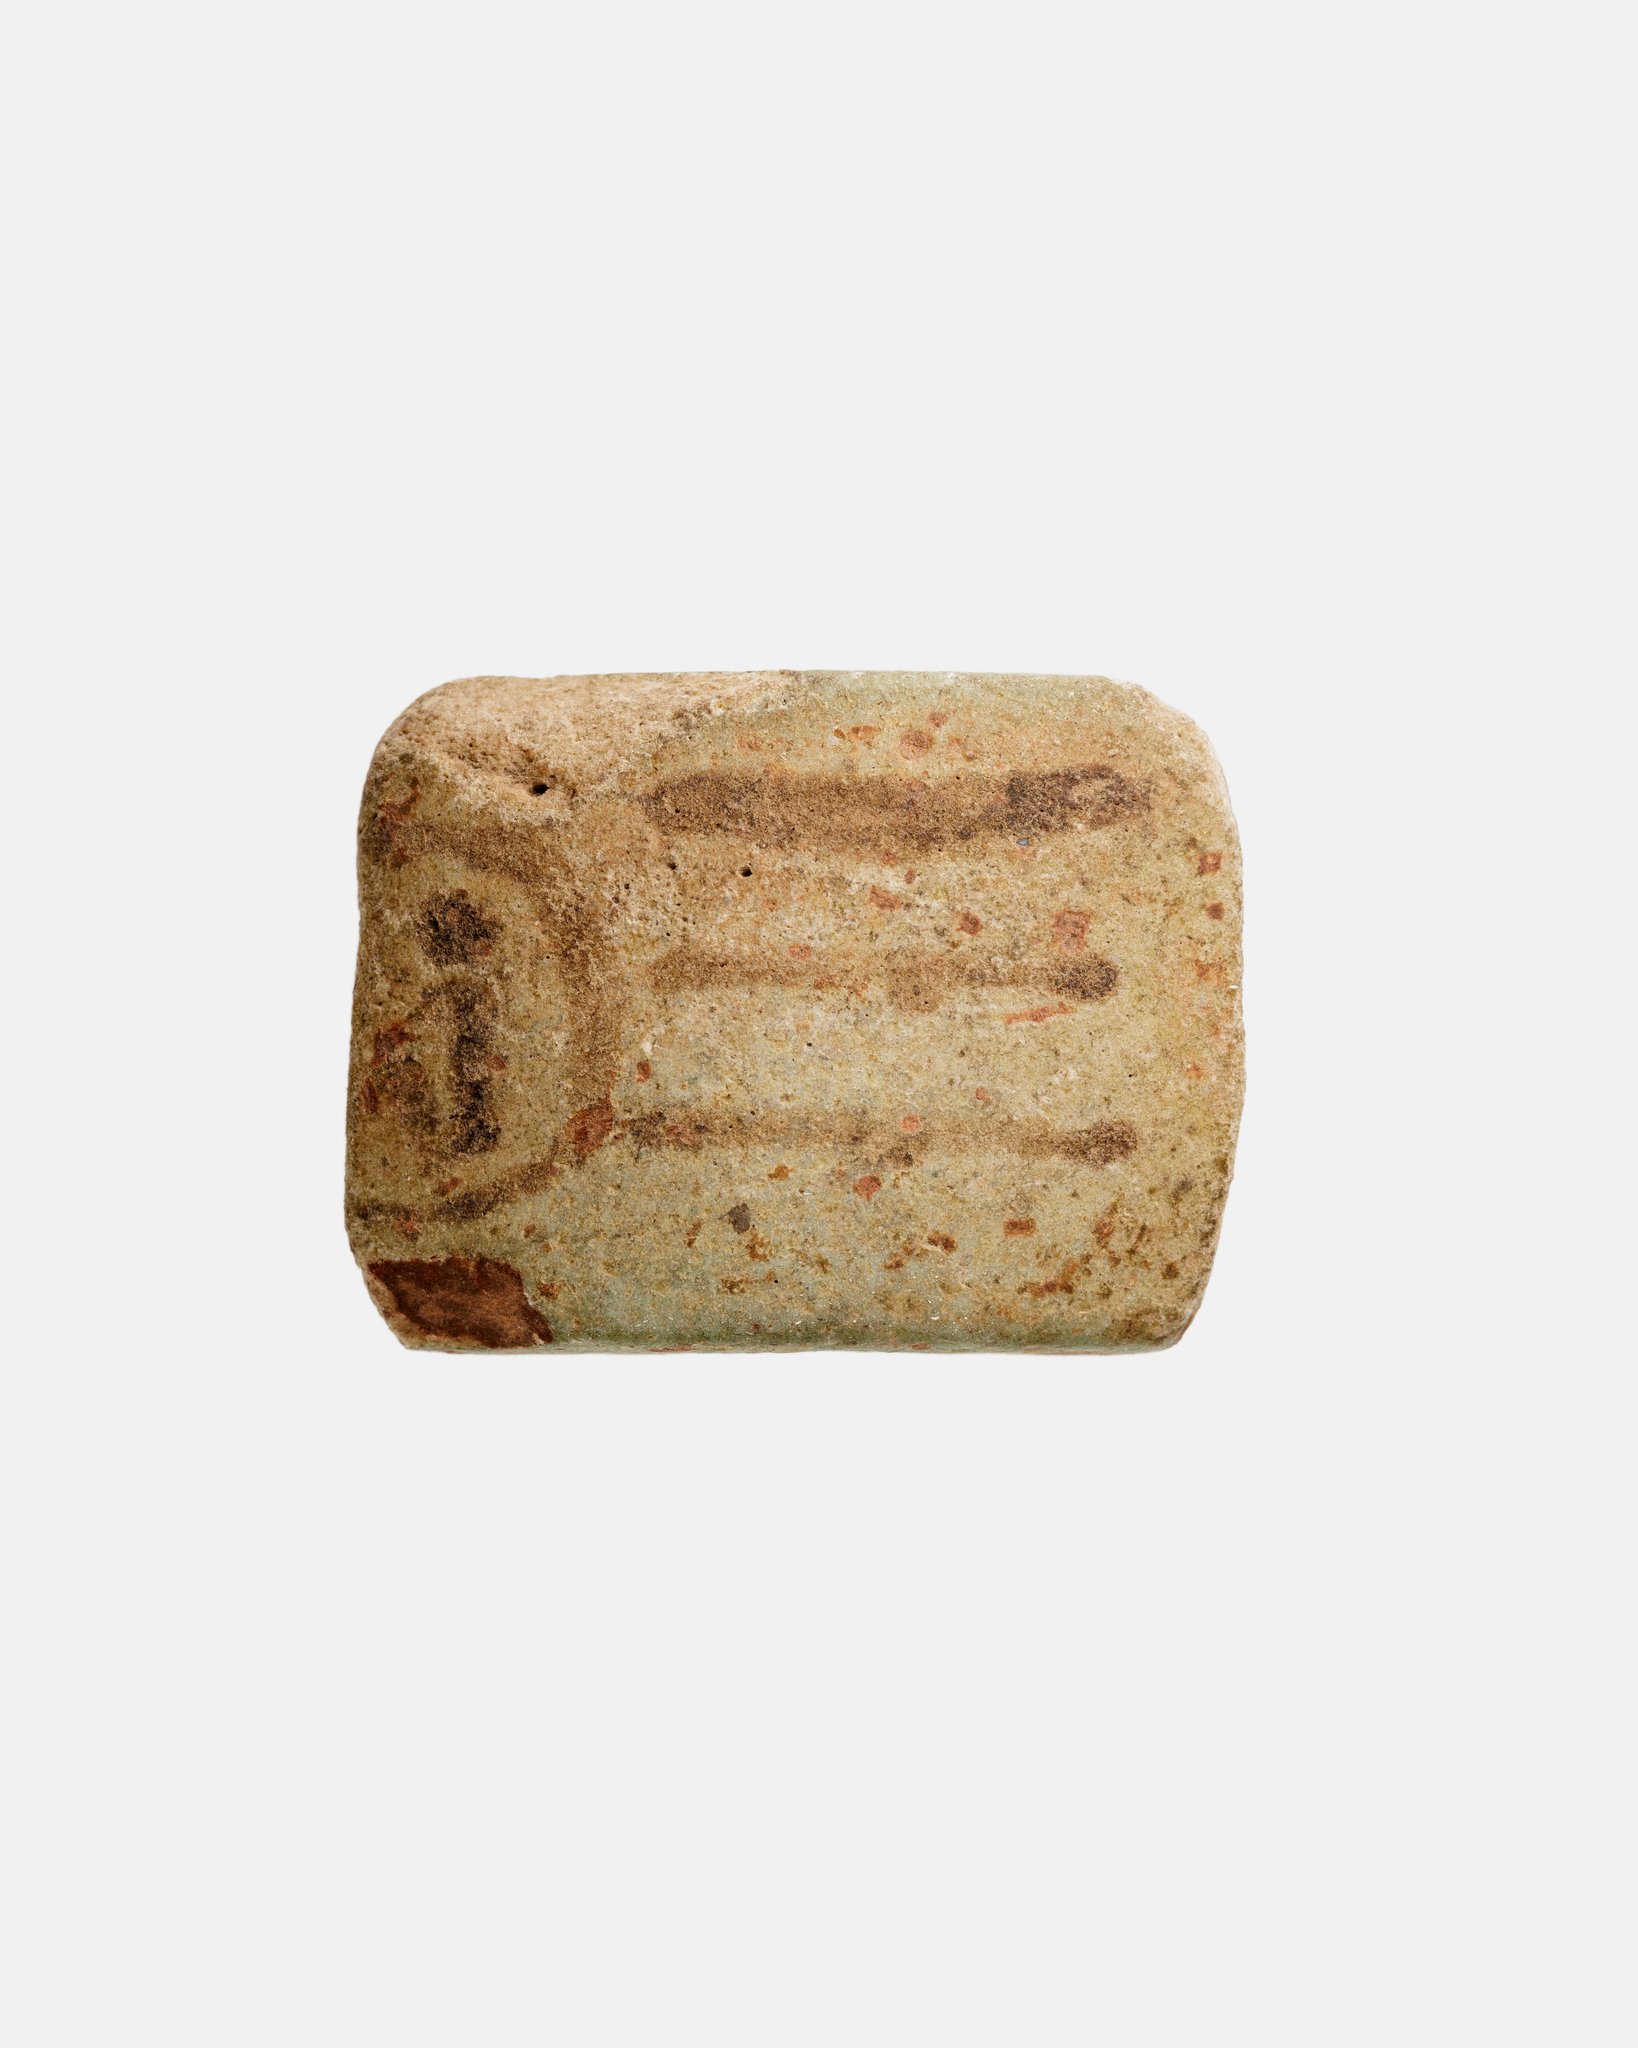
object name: votive bracelet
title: Fragment of a votive bracelet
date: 1295-1070 BCE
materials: faience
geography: egypt